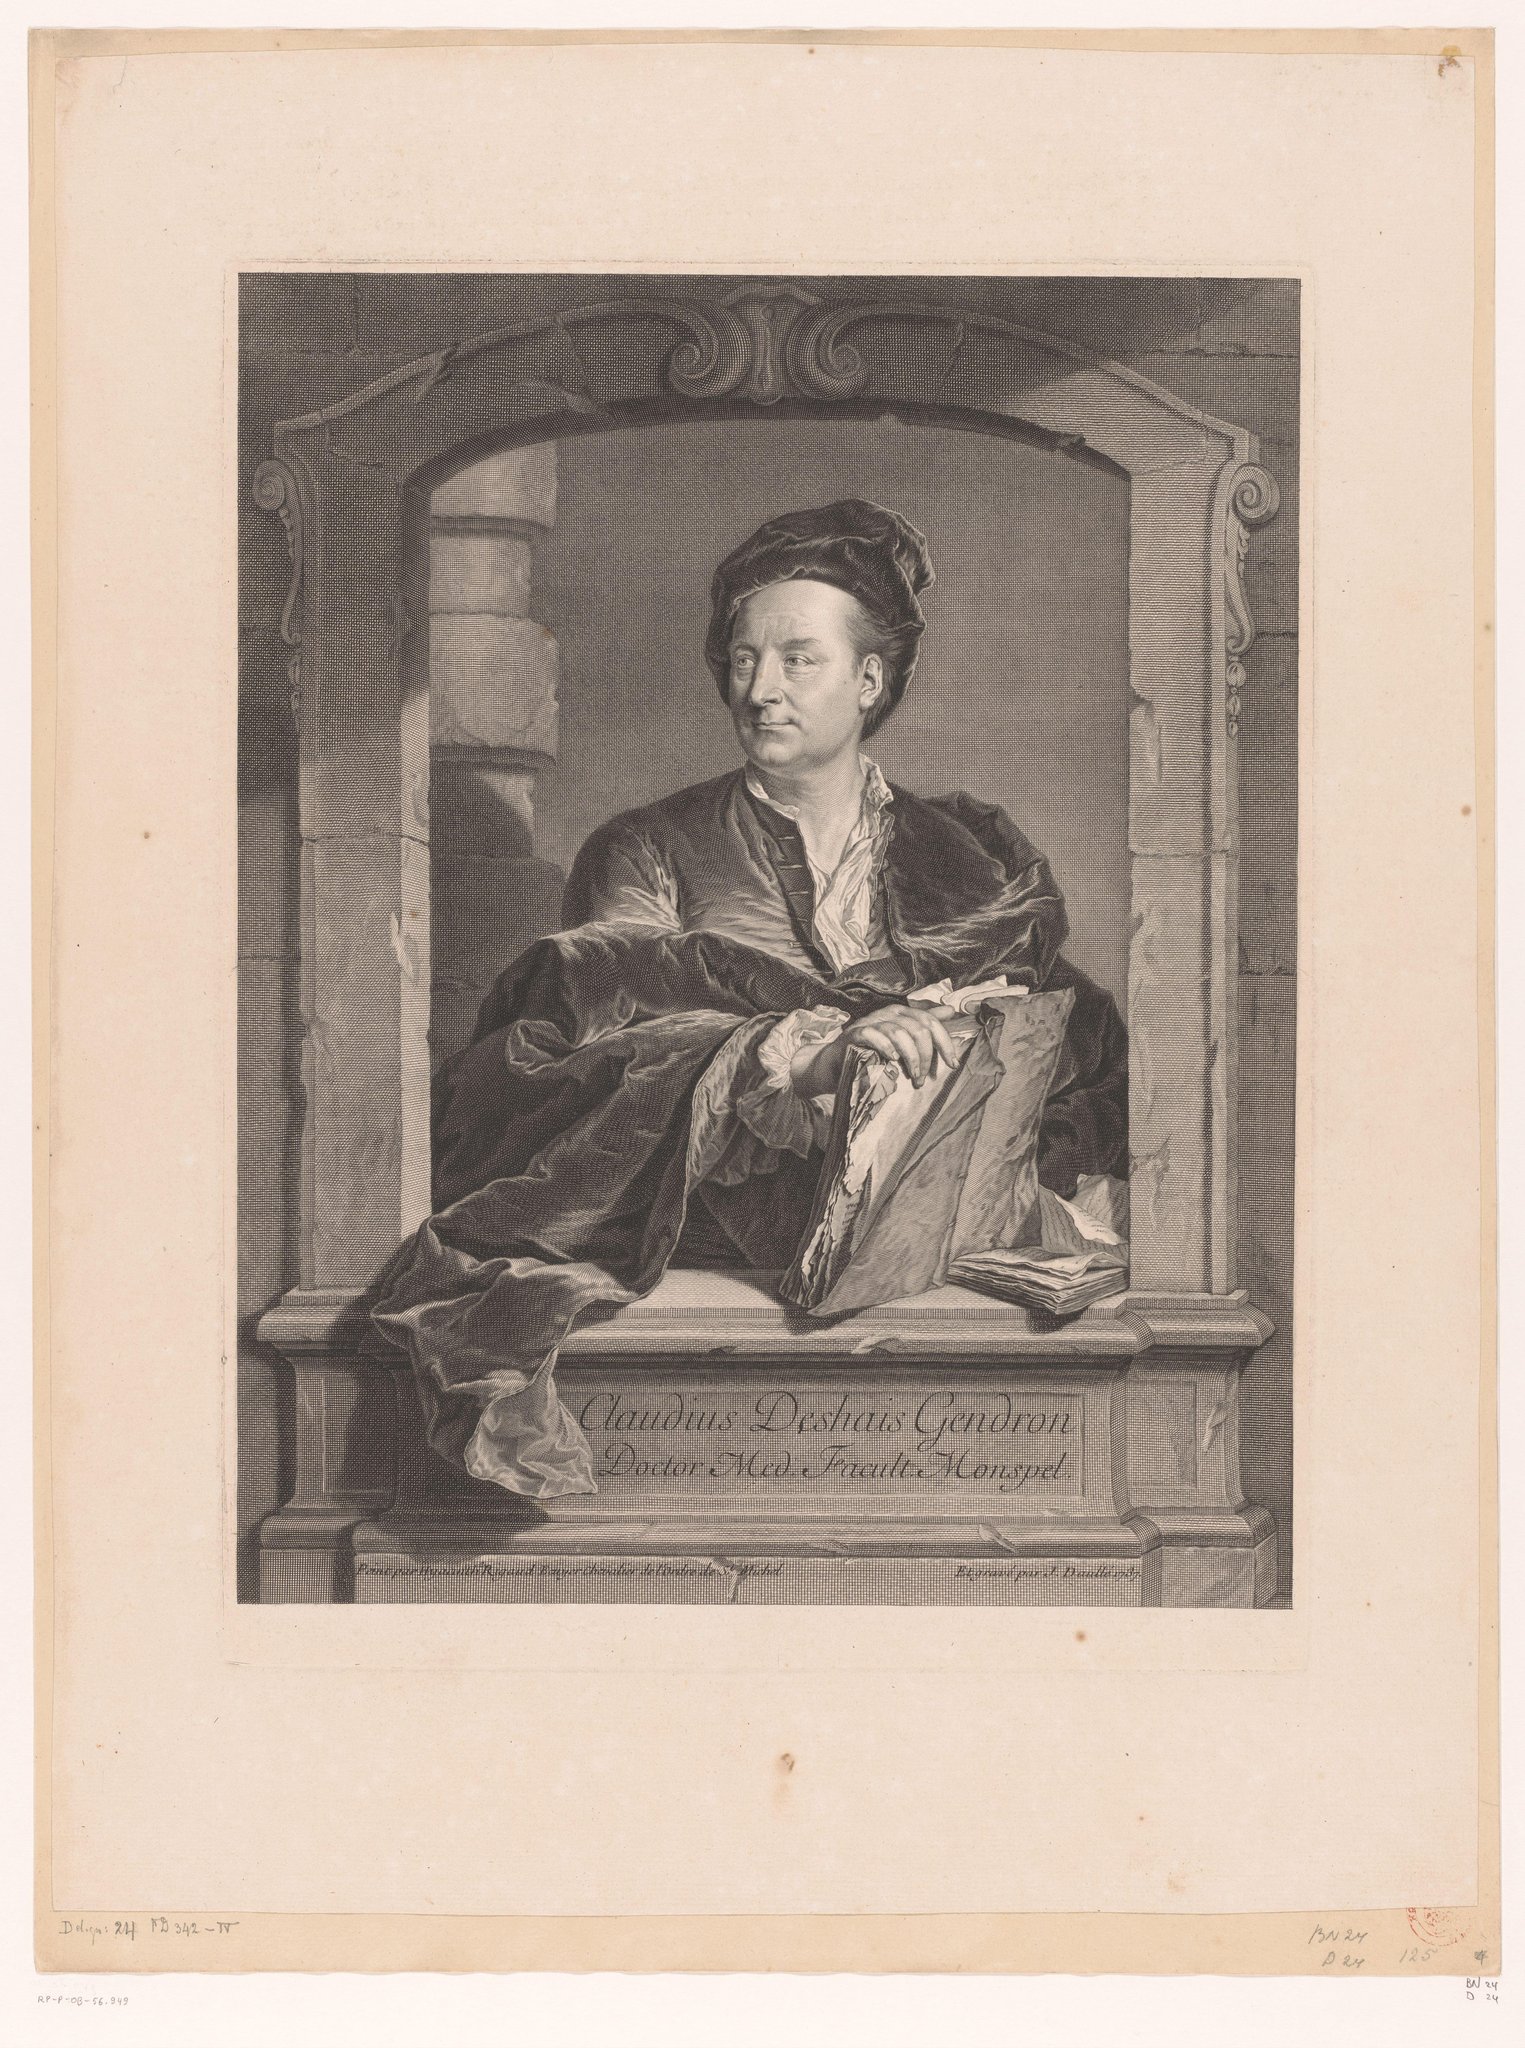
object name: print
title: Portret van Claude Gendron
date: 1737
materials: paper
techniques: engraving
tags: historical persons, physician, doctor, human figure at (open) window, seen from outside - aa - feigned window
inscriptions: collector's mark: Lugt 240